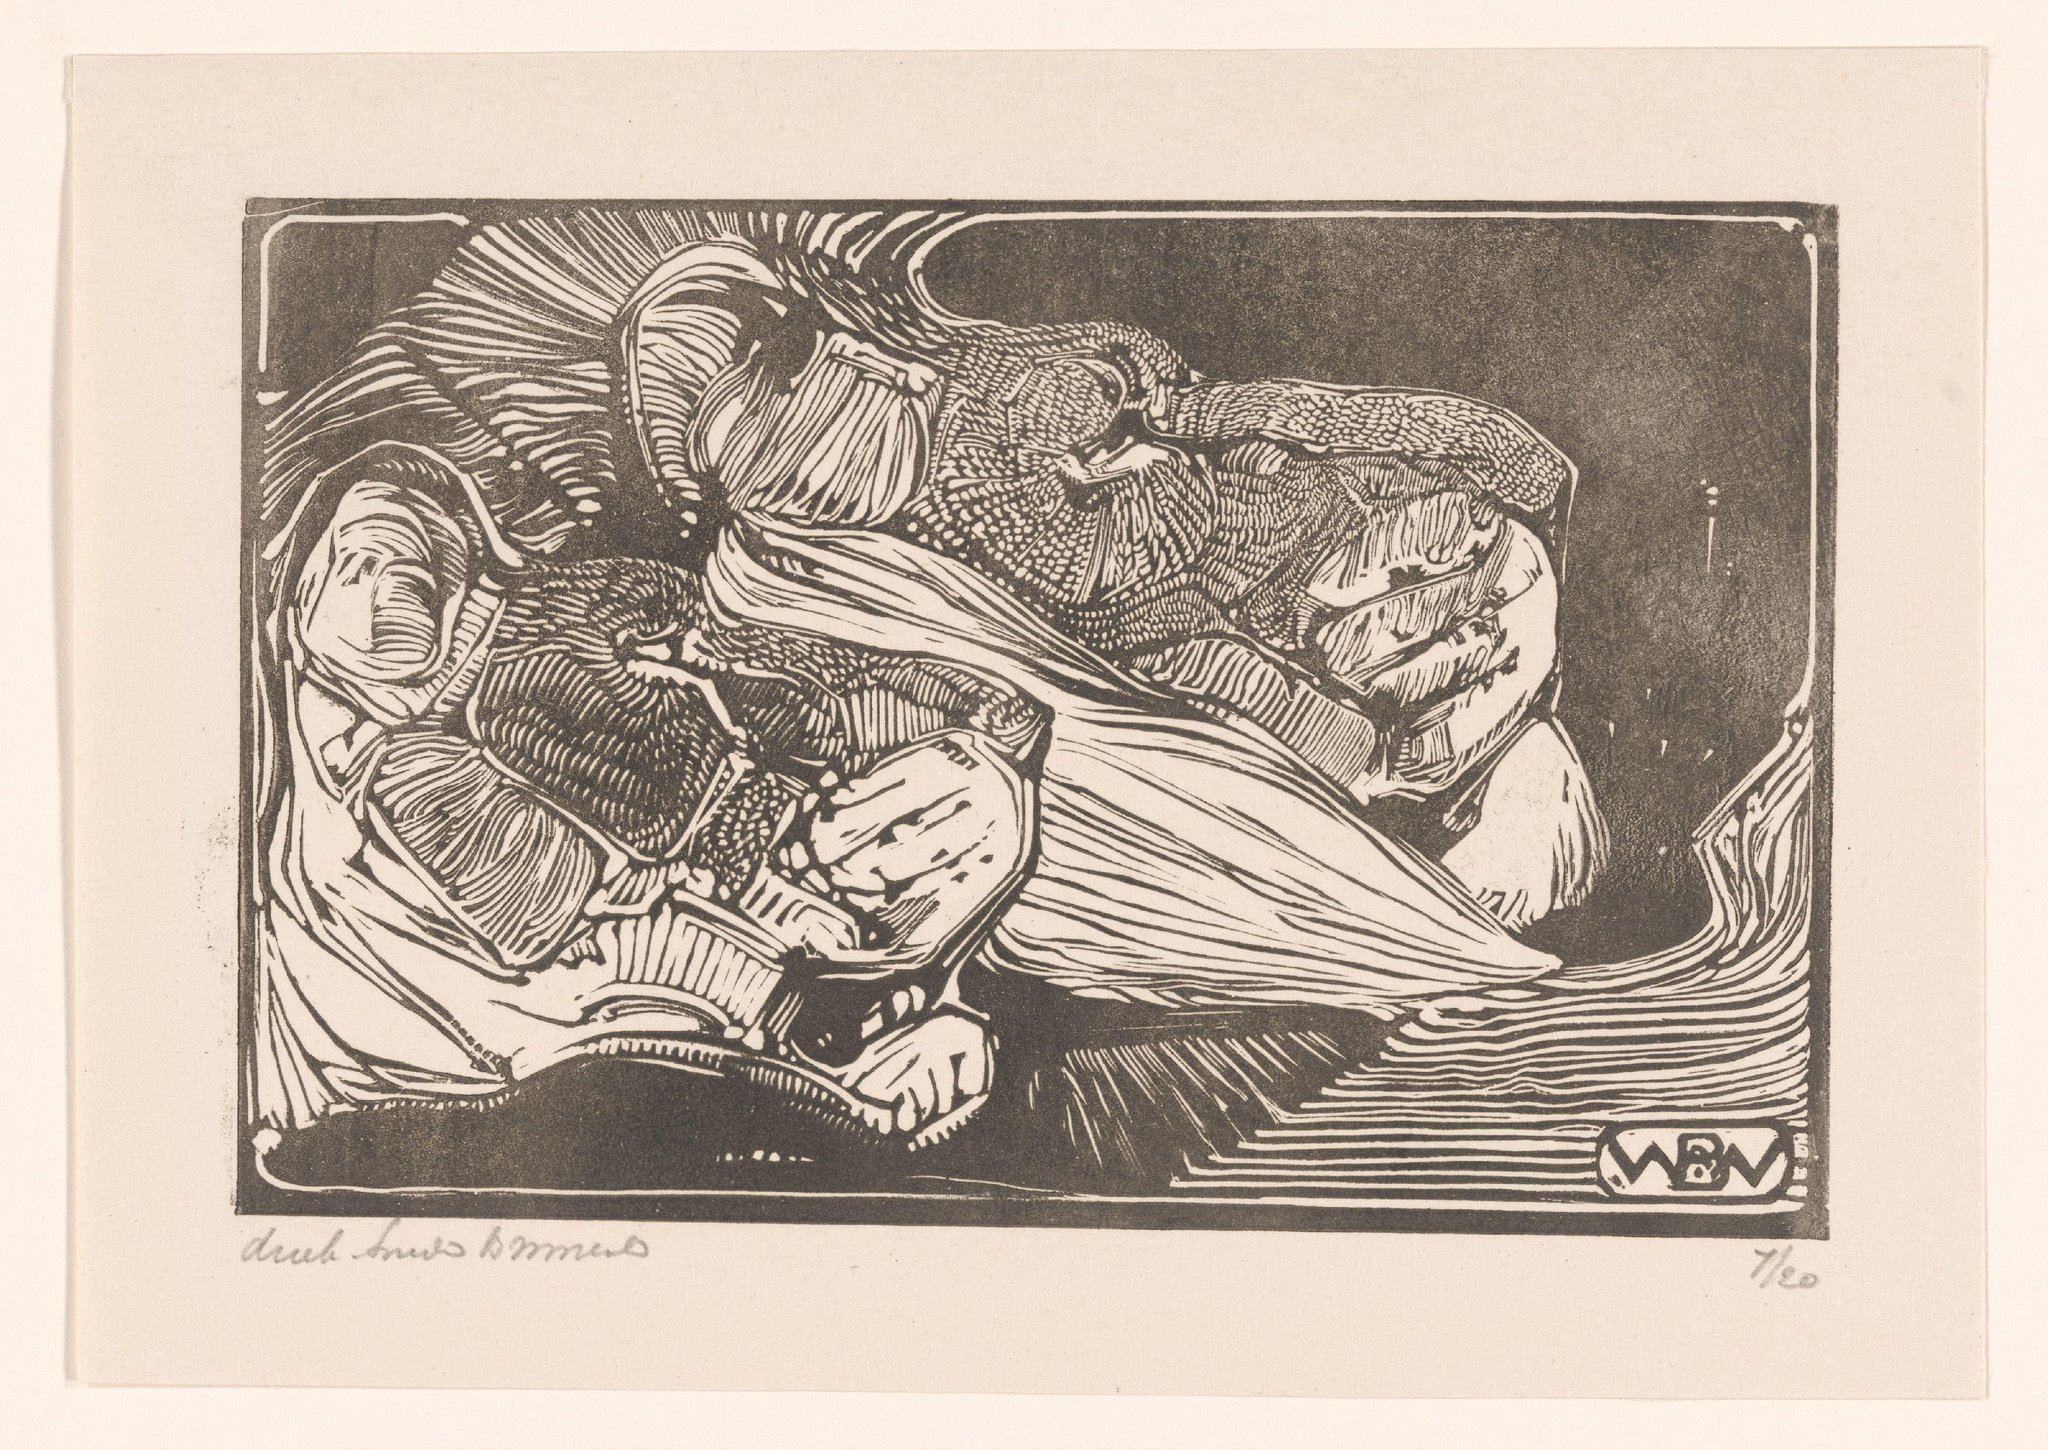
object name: print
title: Leeuw en leeuwin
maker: bernard willem wierink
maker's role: draughtsman, print maker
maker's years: 1856-1939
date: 1918-1919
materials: paper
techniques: relief print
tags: beasts of prey, predatory animals: lion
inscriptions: collector's mark: Lugt 2228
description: Deze prent is vermoedelijk een plaatsnede, ook al wordt in de literatuur veelal gesproken over een houtsnede. Voor zover Wierink zijn prenten in hoogdruk zelf nader heeft omschreven, heeft hij altijd de term 'plaatsnede' gebruikt.